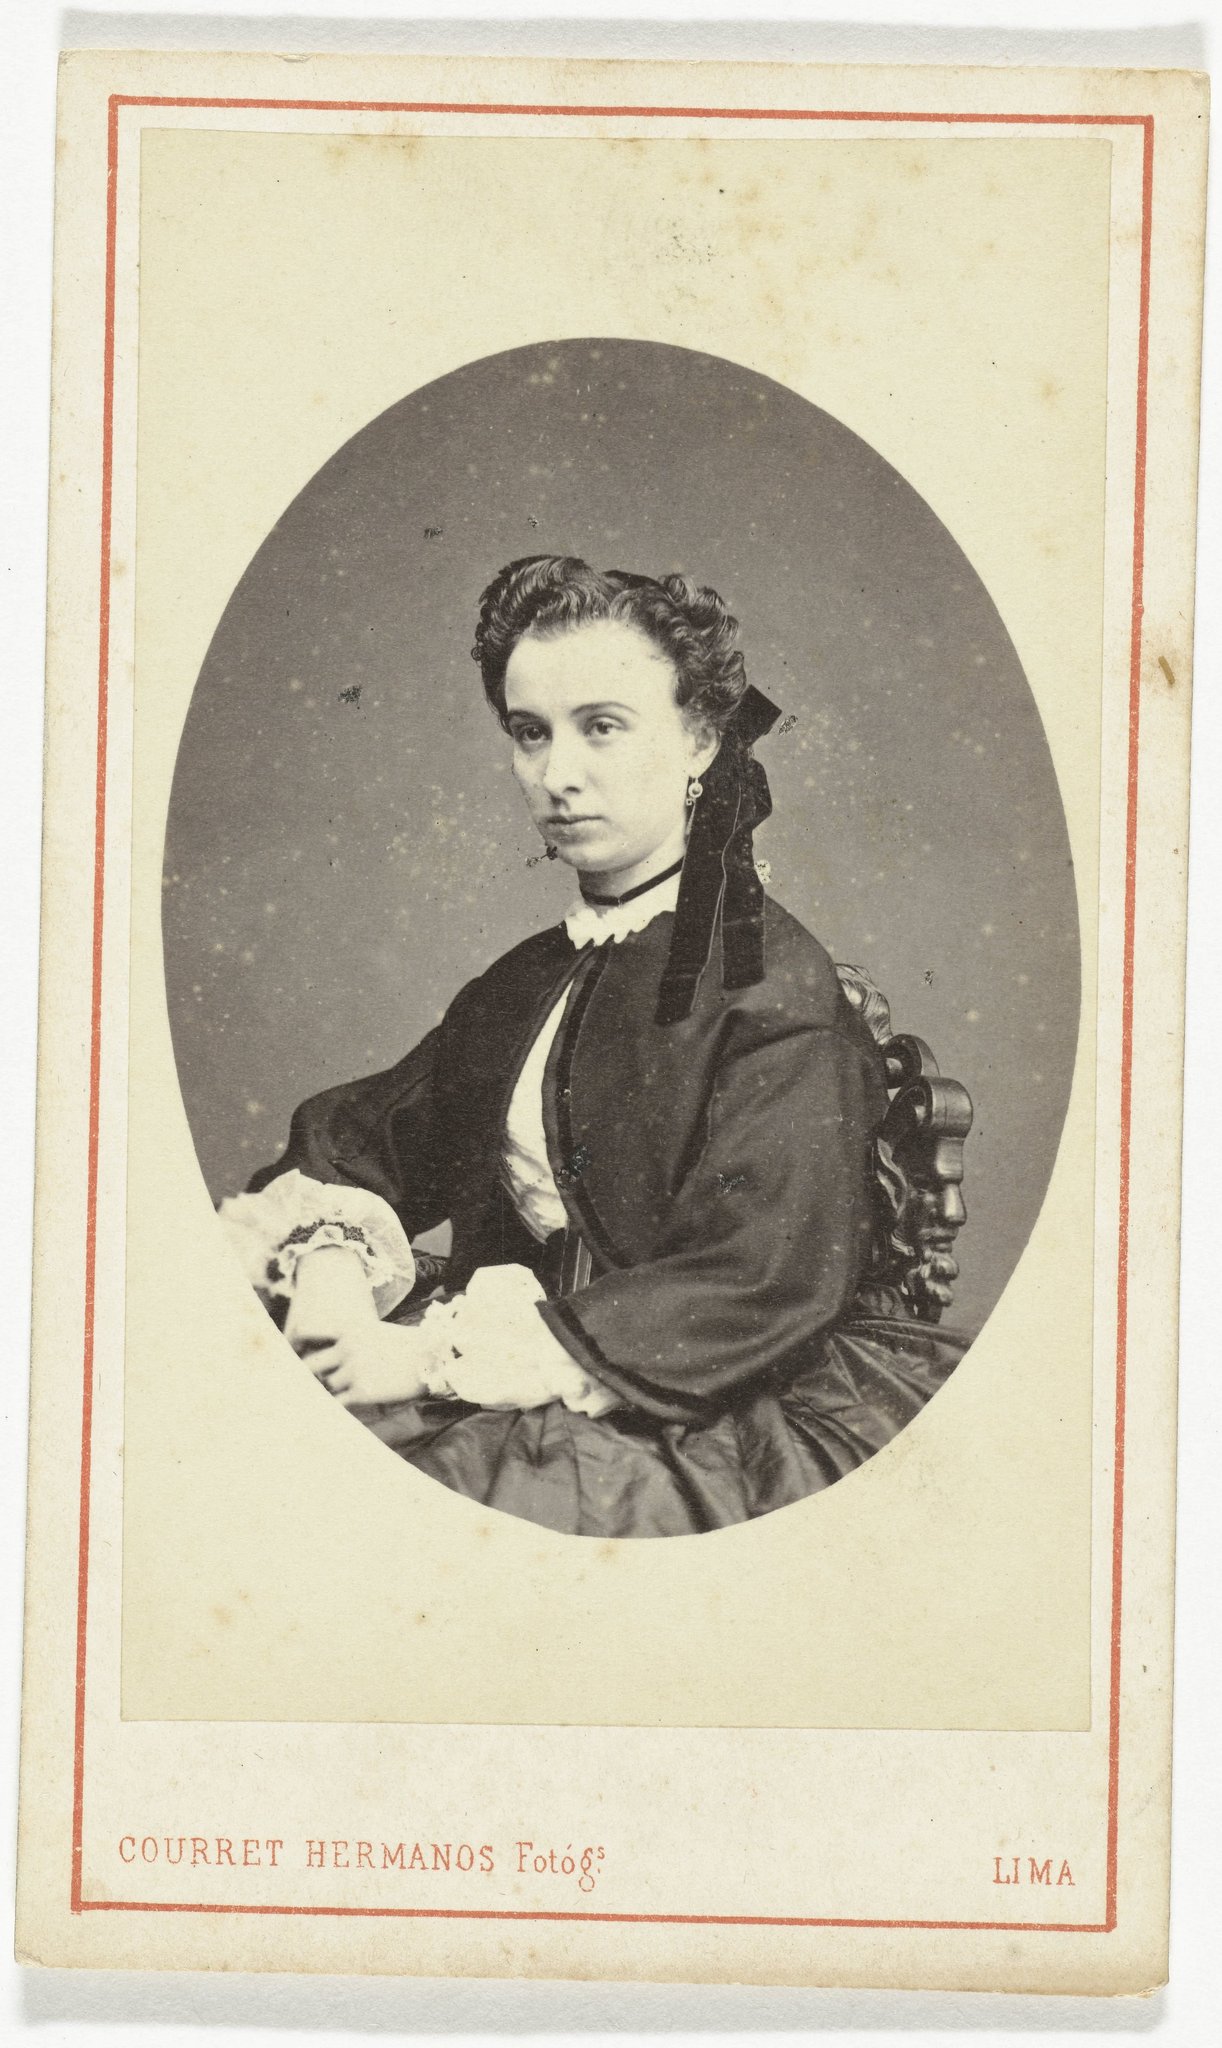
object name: photograph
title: Portret van Orfa Ducla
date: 1860-1900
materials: cardboard, photographic support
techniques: albumen print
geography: lima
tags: historical persons - bb - woman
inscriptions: annotation: ‘A mi querida amiguita/ Virginia Sandoval/ Enero 8 de 1866/ Orfa Ducla’, address: ‘COURRET HERMANOS/ Fotógrafos/ Calle mercaderes (Union) No. 197/ LIMA/ Para Consequir Retratos iguales a este/ Bastara indicarnos el No. de la Plancha’